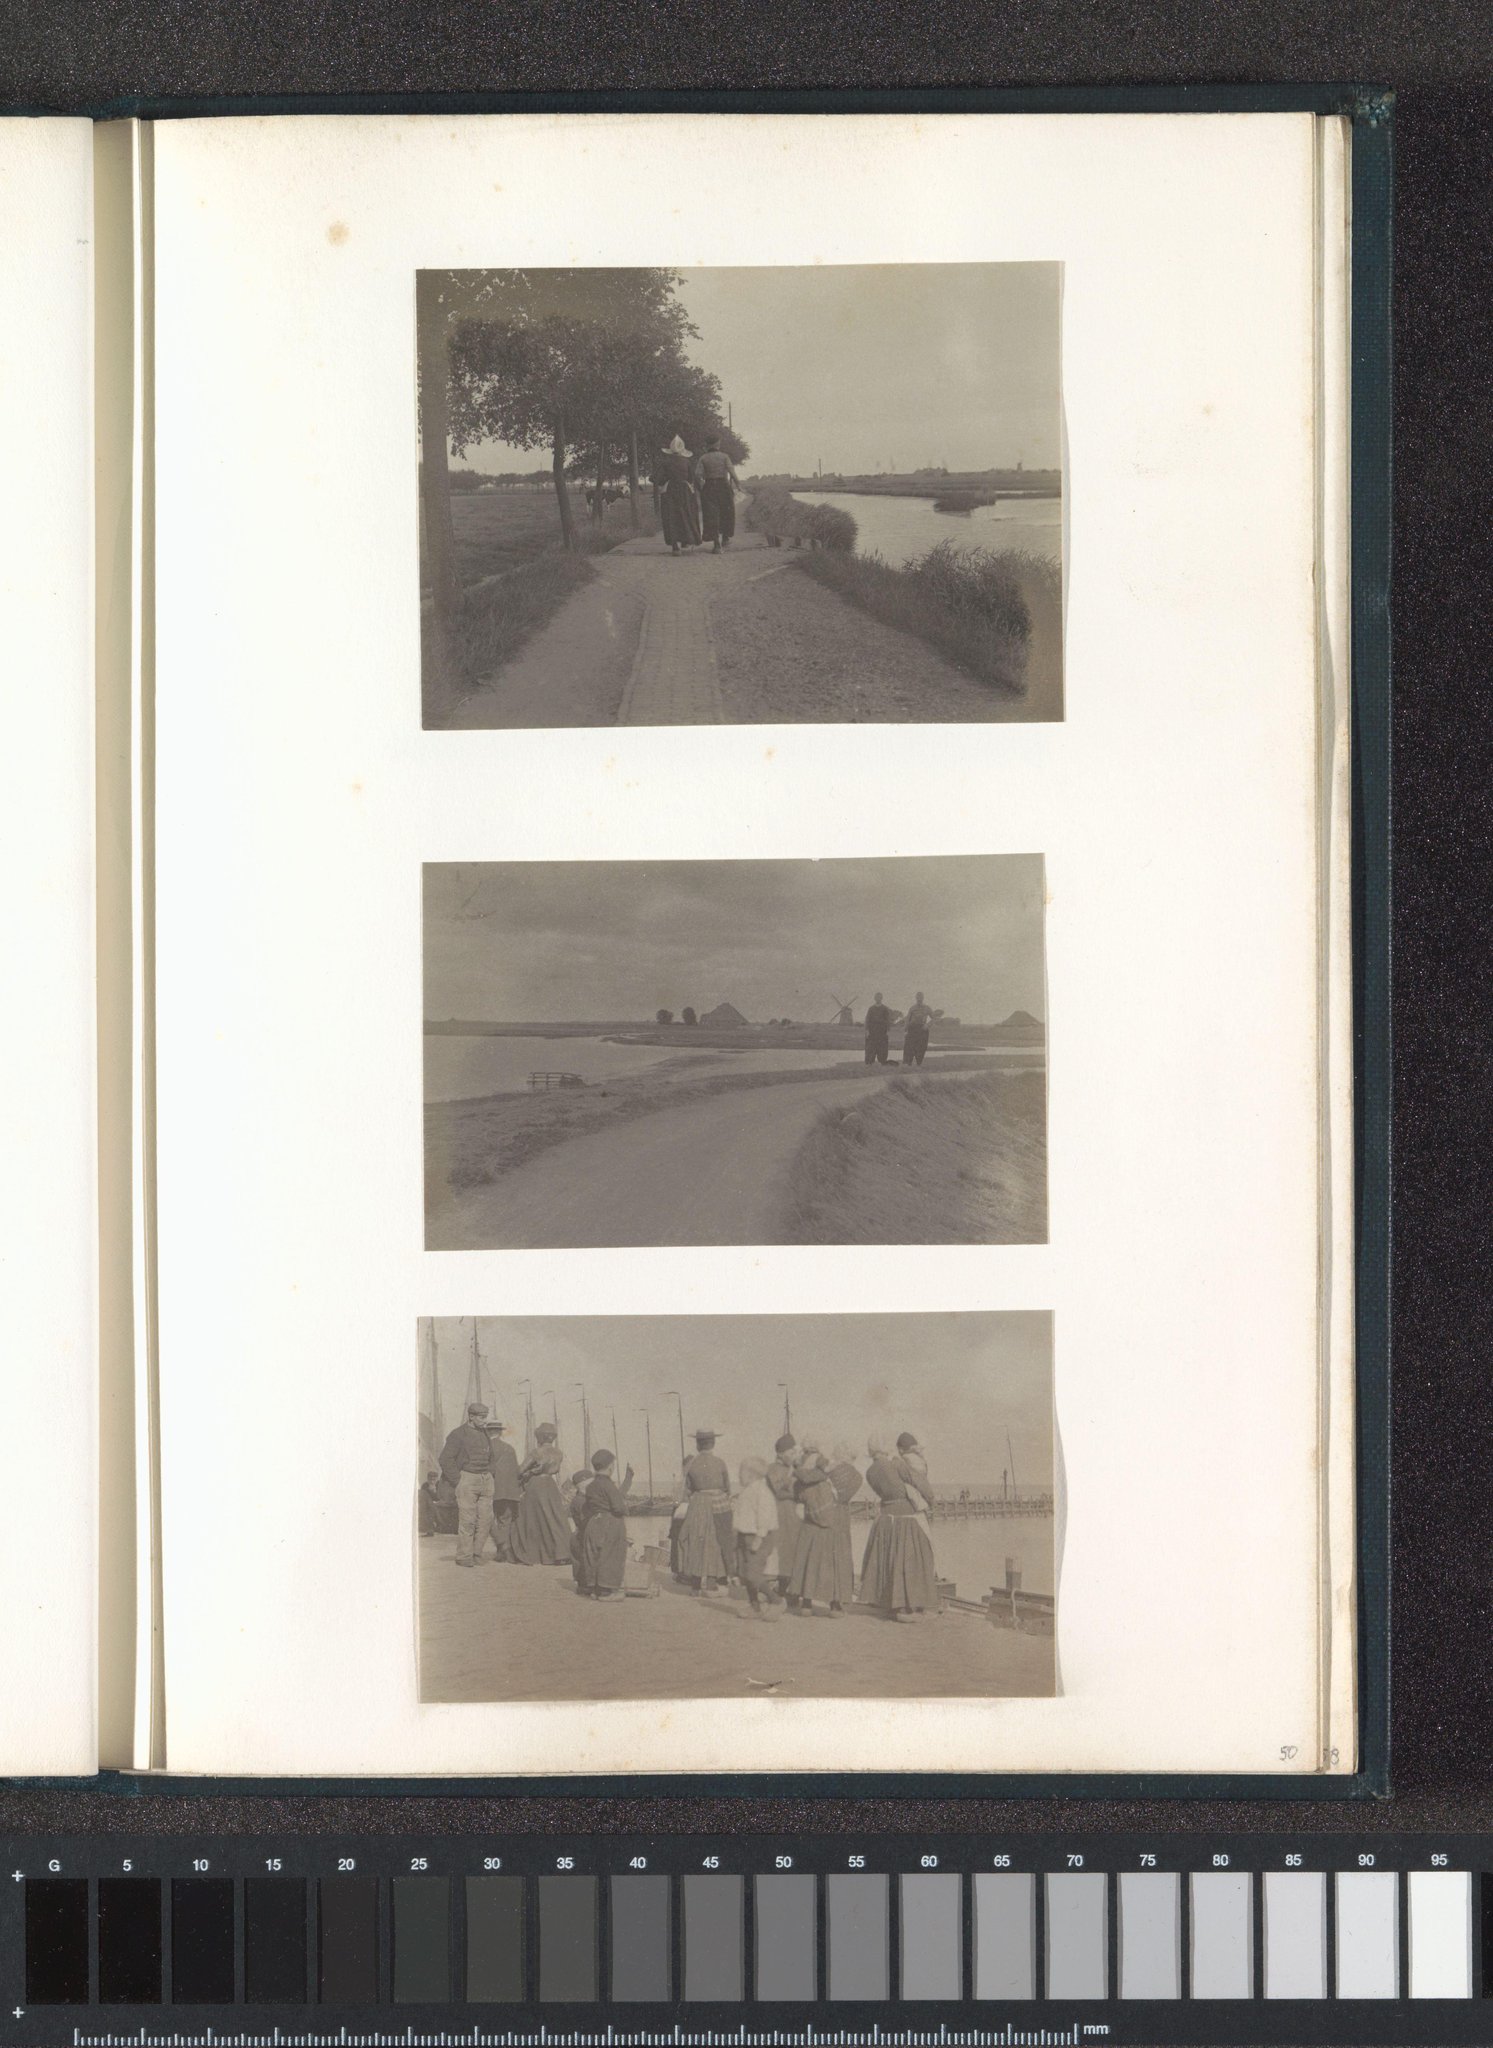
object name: photograph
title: Groep mannen, vrouwen en kinderen in klederdracht op de kade bij Volendam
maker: george hidderley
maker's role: fotograaf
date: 1900-1910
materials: paper, photographic support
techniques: gelatin silver print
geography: volendam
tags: folk costume, regional costume (+ women's clothes), folk costume, regional costume (+ men's clothes), pier, quay, wharf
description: Onderdeel van fotoalbum met opnames van Volendam, Dordrecht, Gorinchem en Woudrichem.